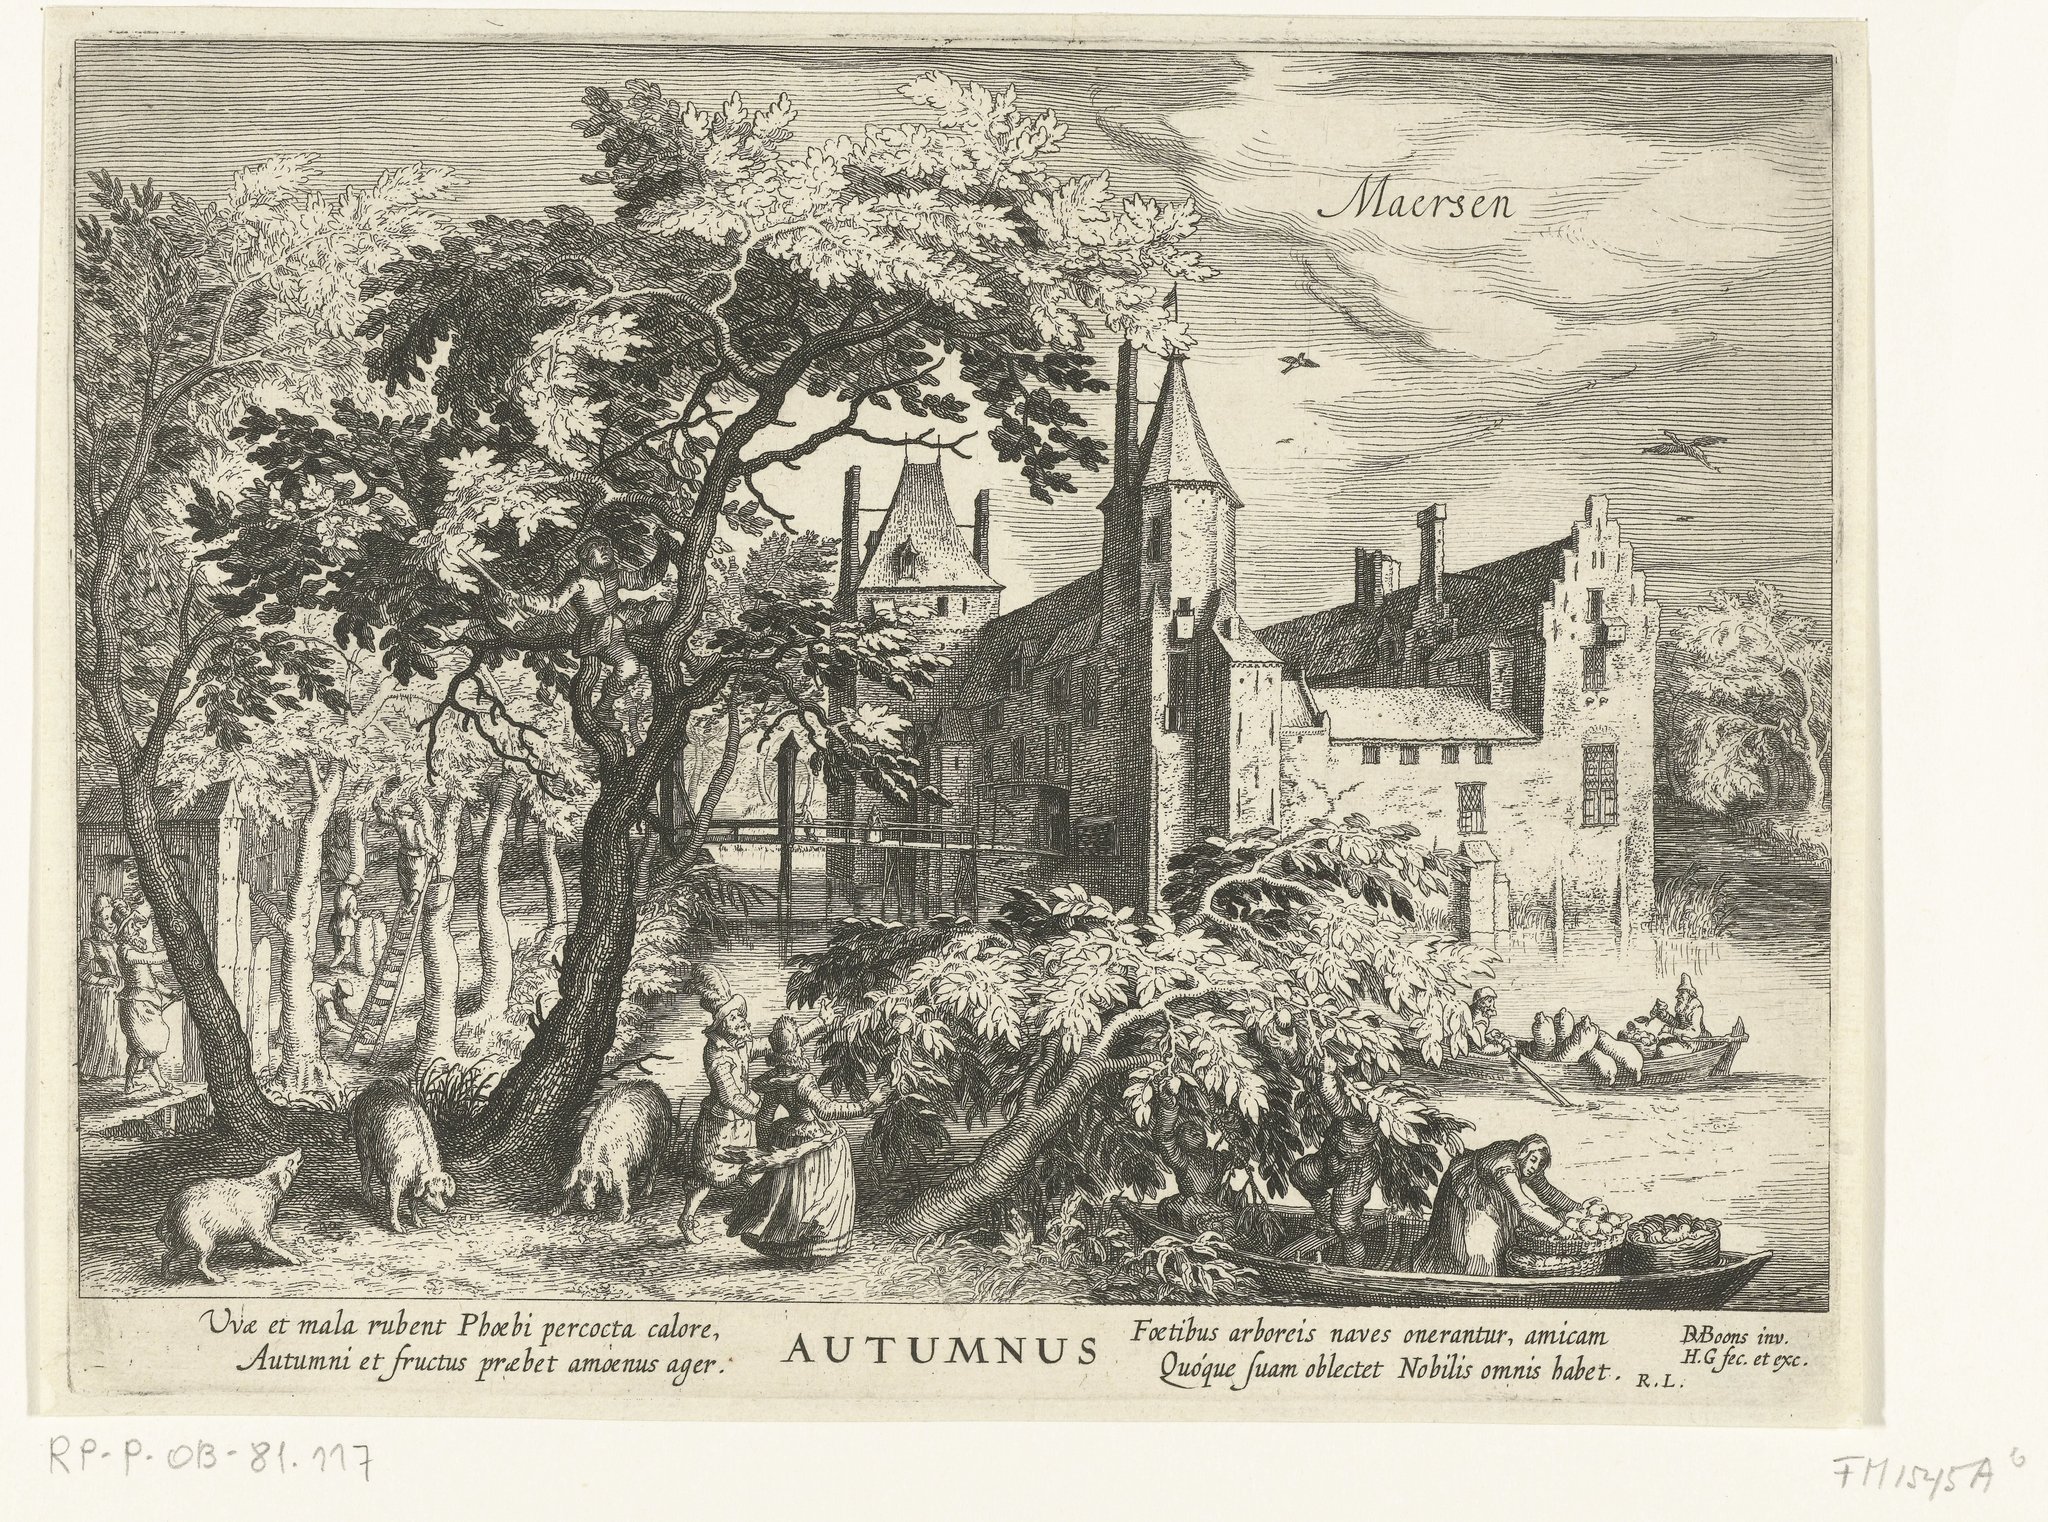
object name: print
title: Autumnus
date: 1620-1629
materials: paper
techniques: etching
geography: northern netherlands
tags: autumn ~ human activities (the four seasons of the year)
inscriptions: collector's mark: Lugt 384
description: Het seizoen herfst. Op de voorgrond een elegant paar, rechts en links het oogsten door boeren bij het Huis ter Meer te Maarssen. Met onderschrift van 4 regels in het Latijn.